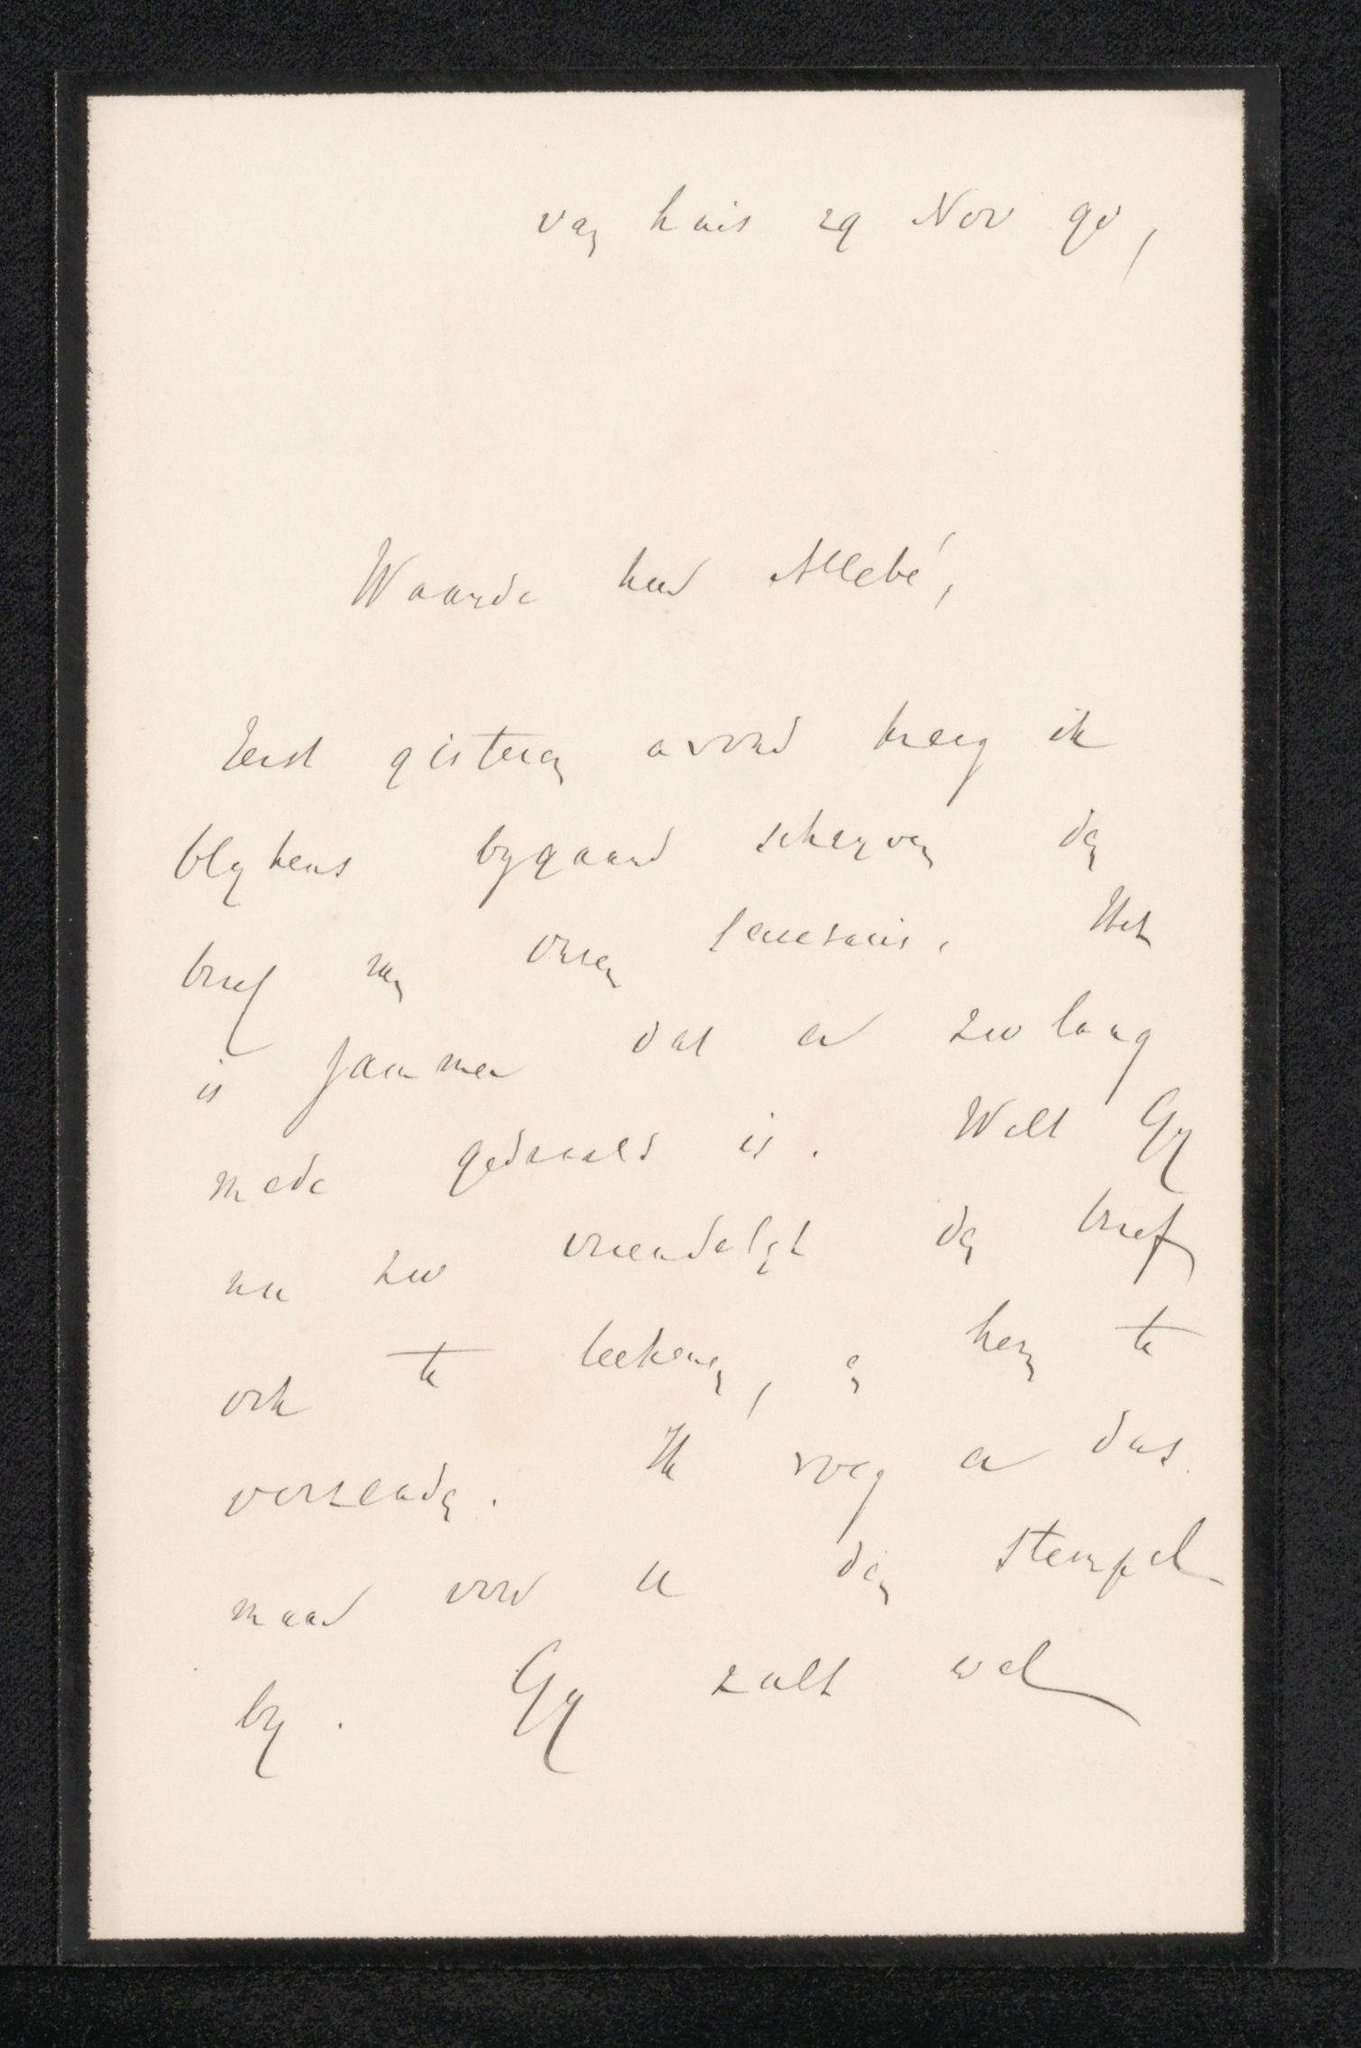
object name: letter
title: Brief aan August Allebé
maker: hendrick peter godfried quack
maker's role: econoom, geschiedschrijver, hoogleraar, jurist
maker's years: 1834-1917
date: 1890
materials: ink, paper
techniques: pen, writing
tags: print maker, draughtsman, august allebé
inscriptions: watermark